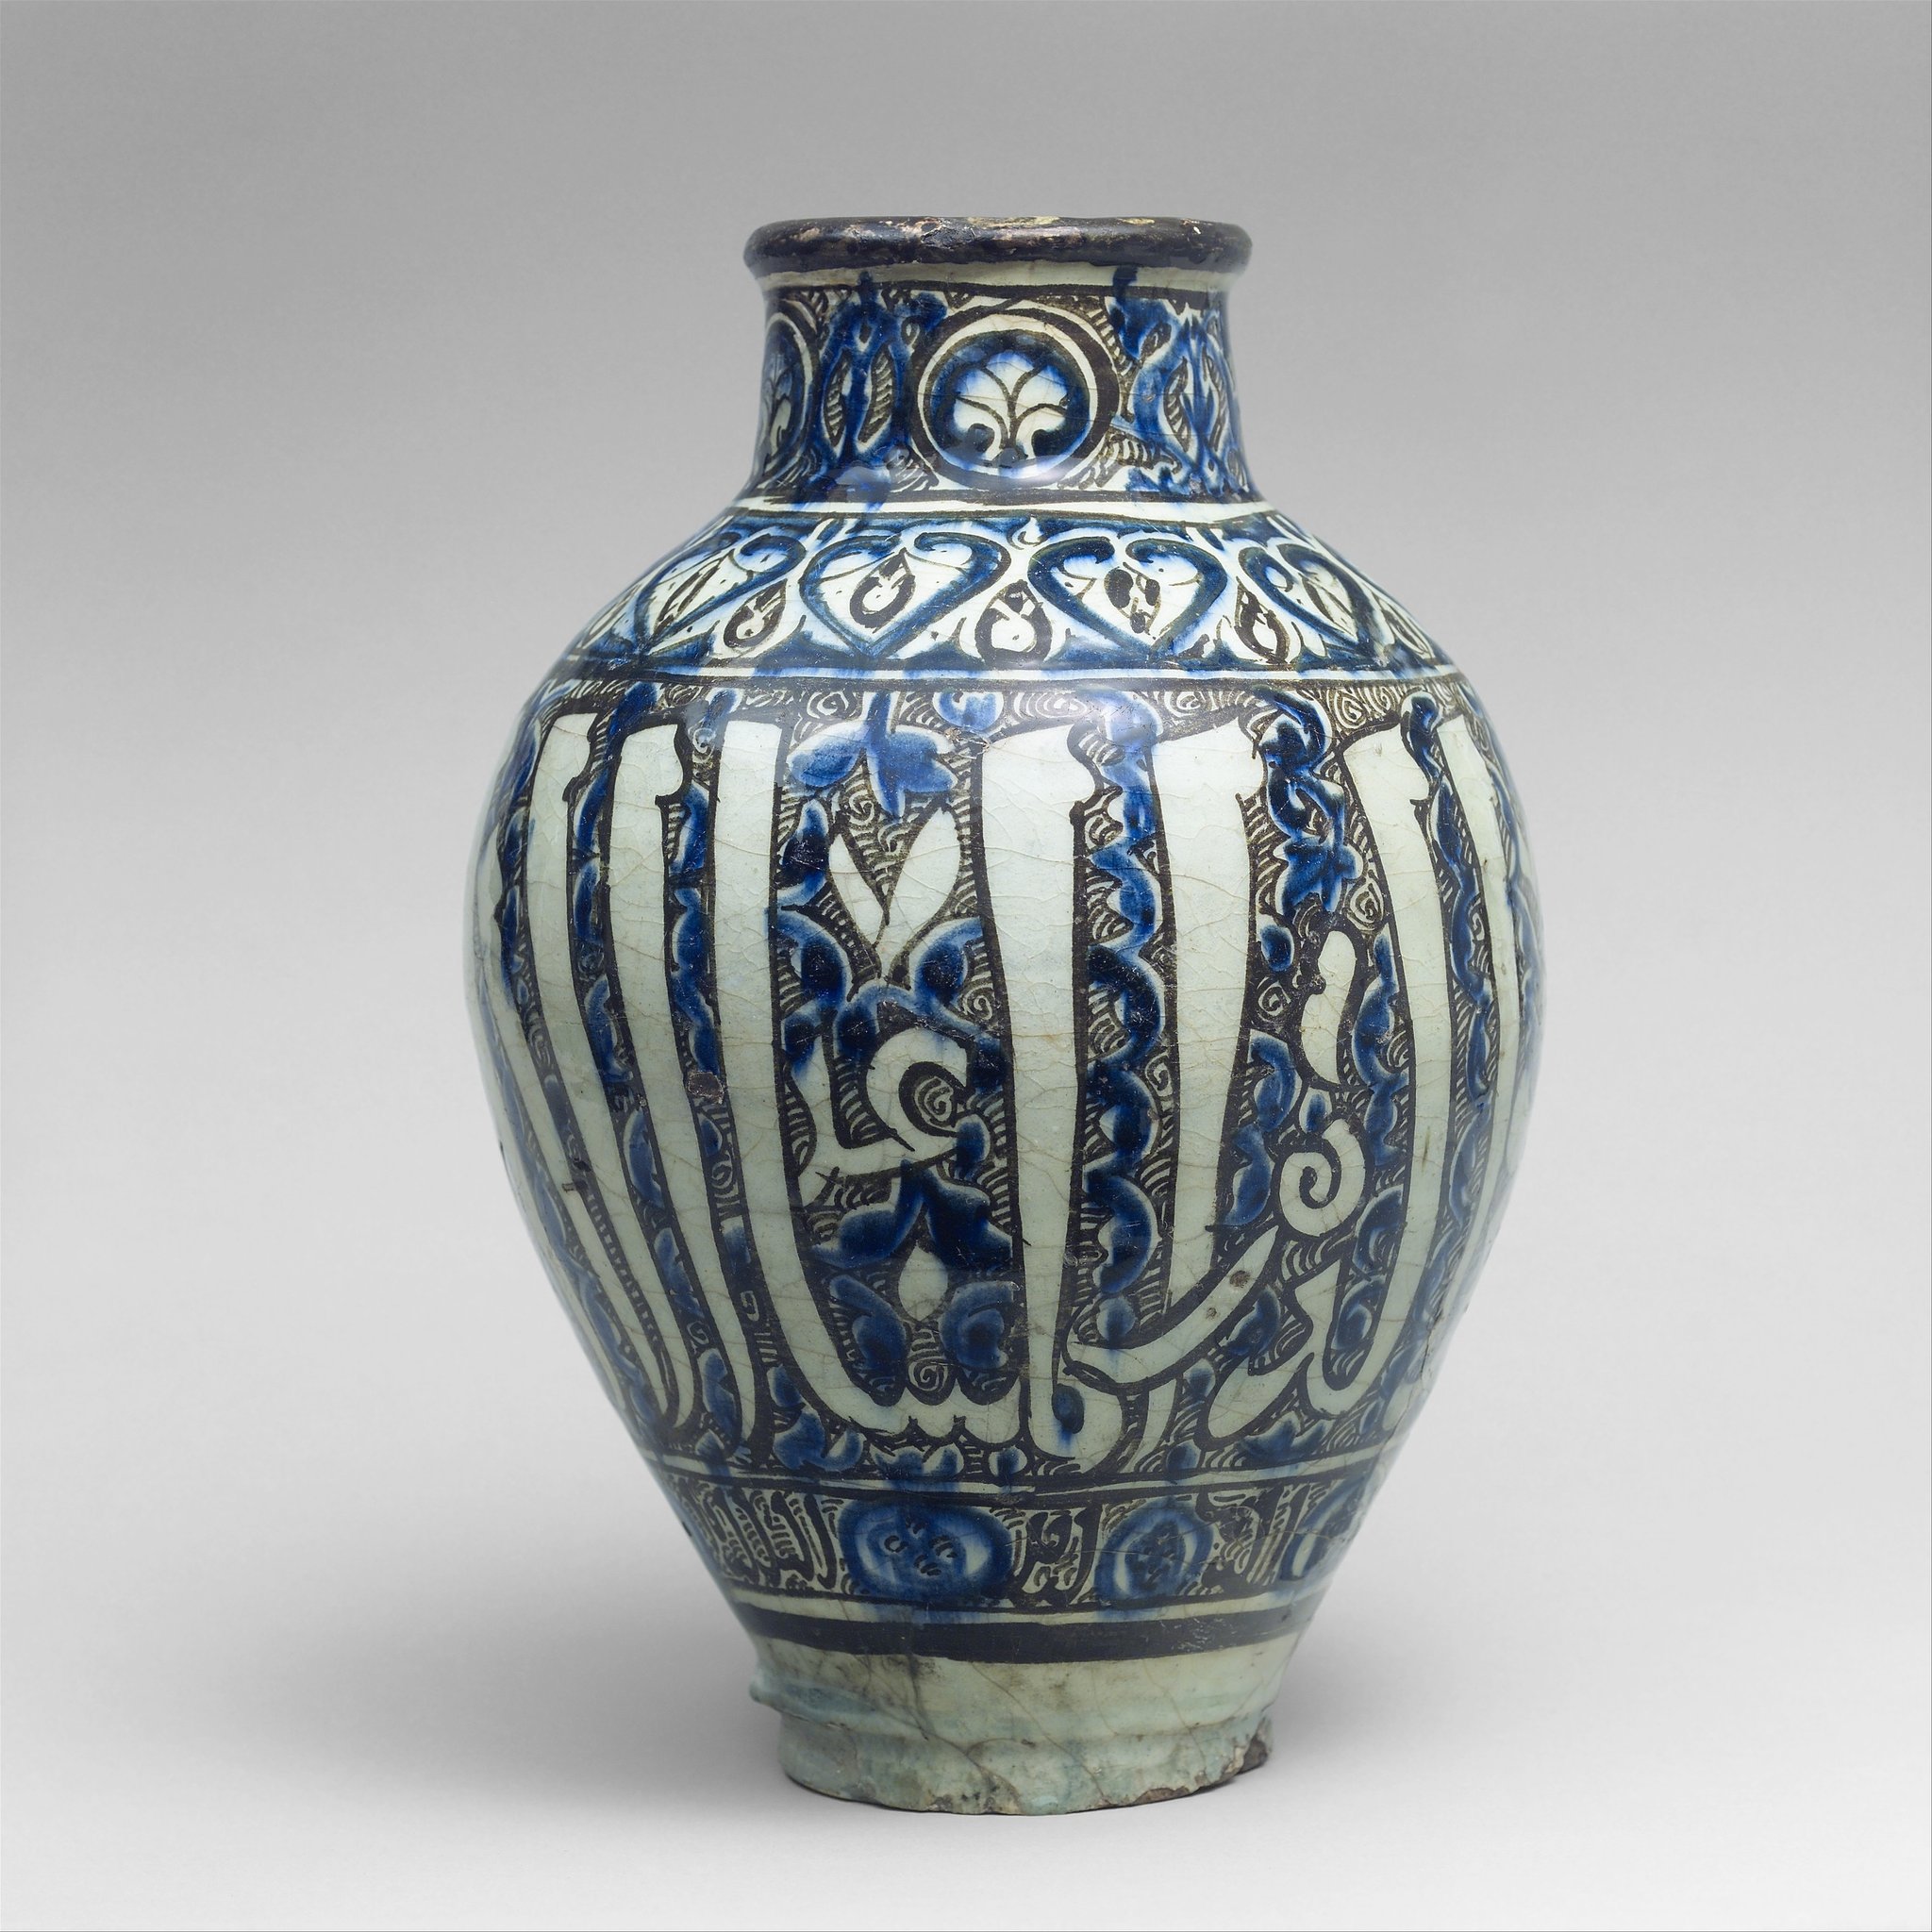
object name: jar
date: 1301-1400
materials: glaze, stonepaste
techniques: painting, polychrome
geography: syria